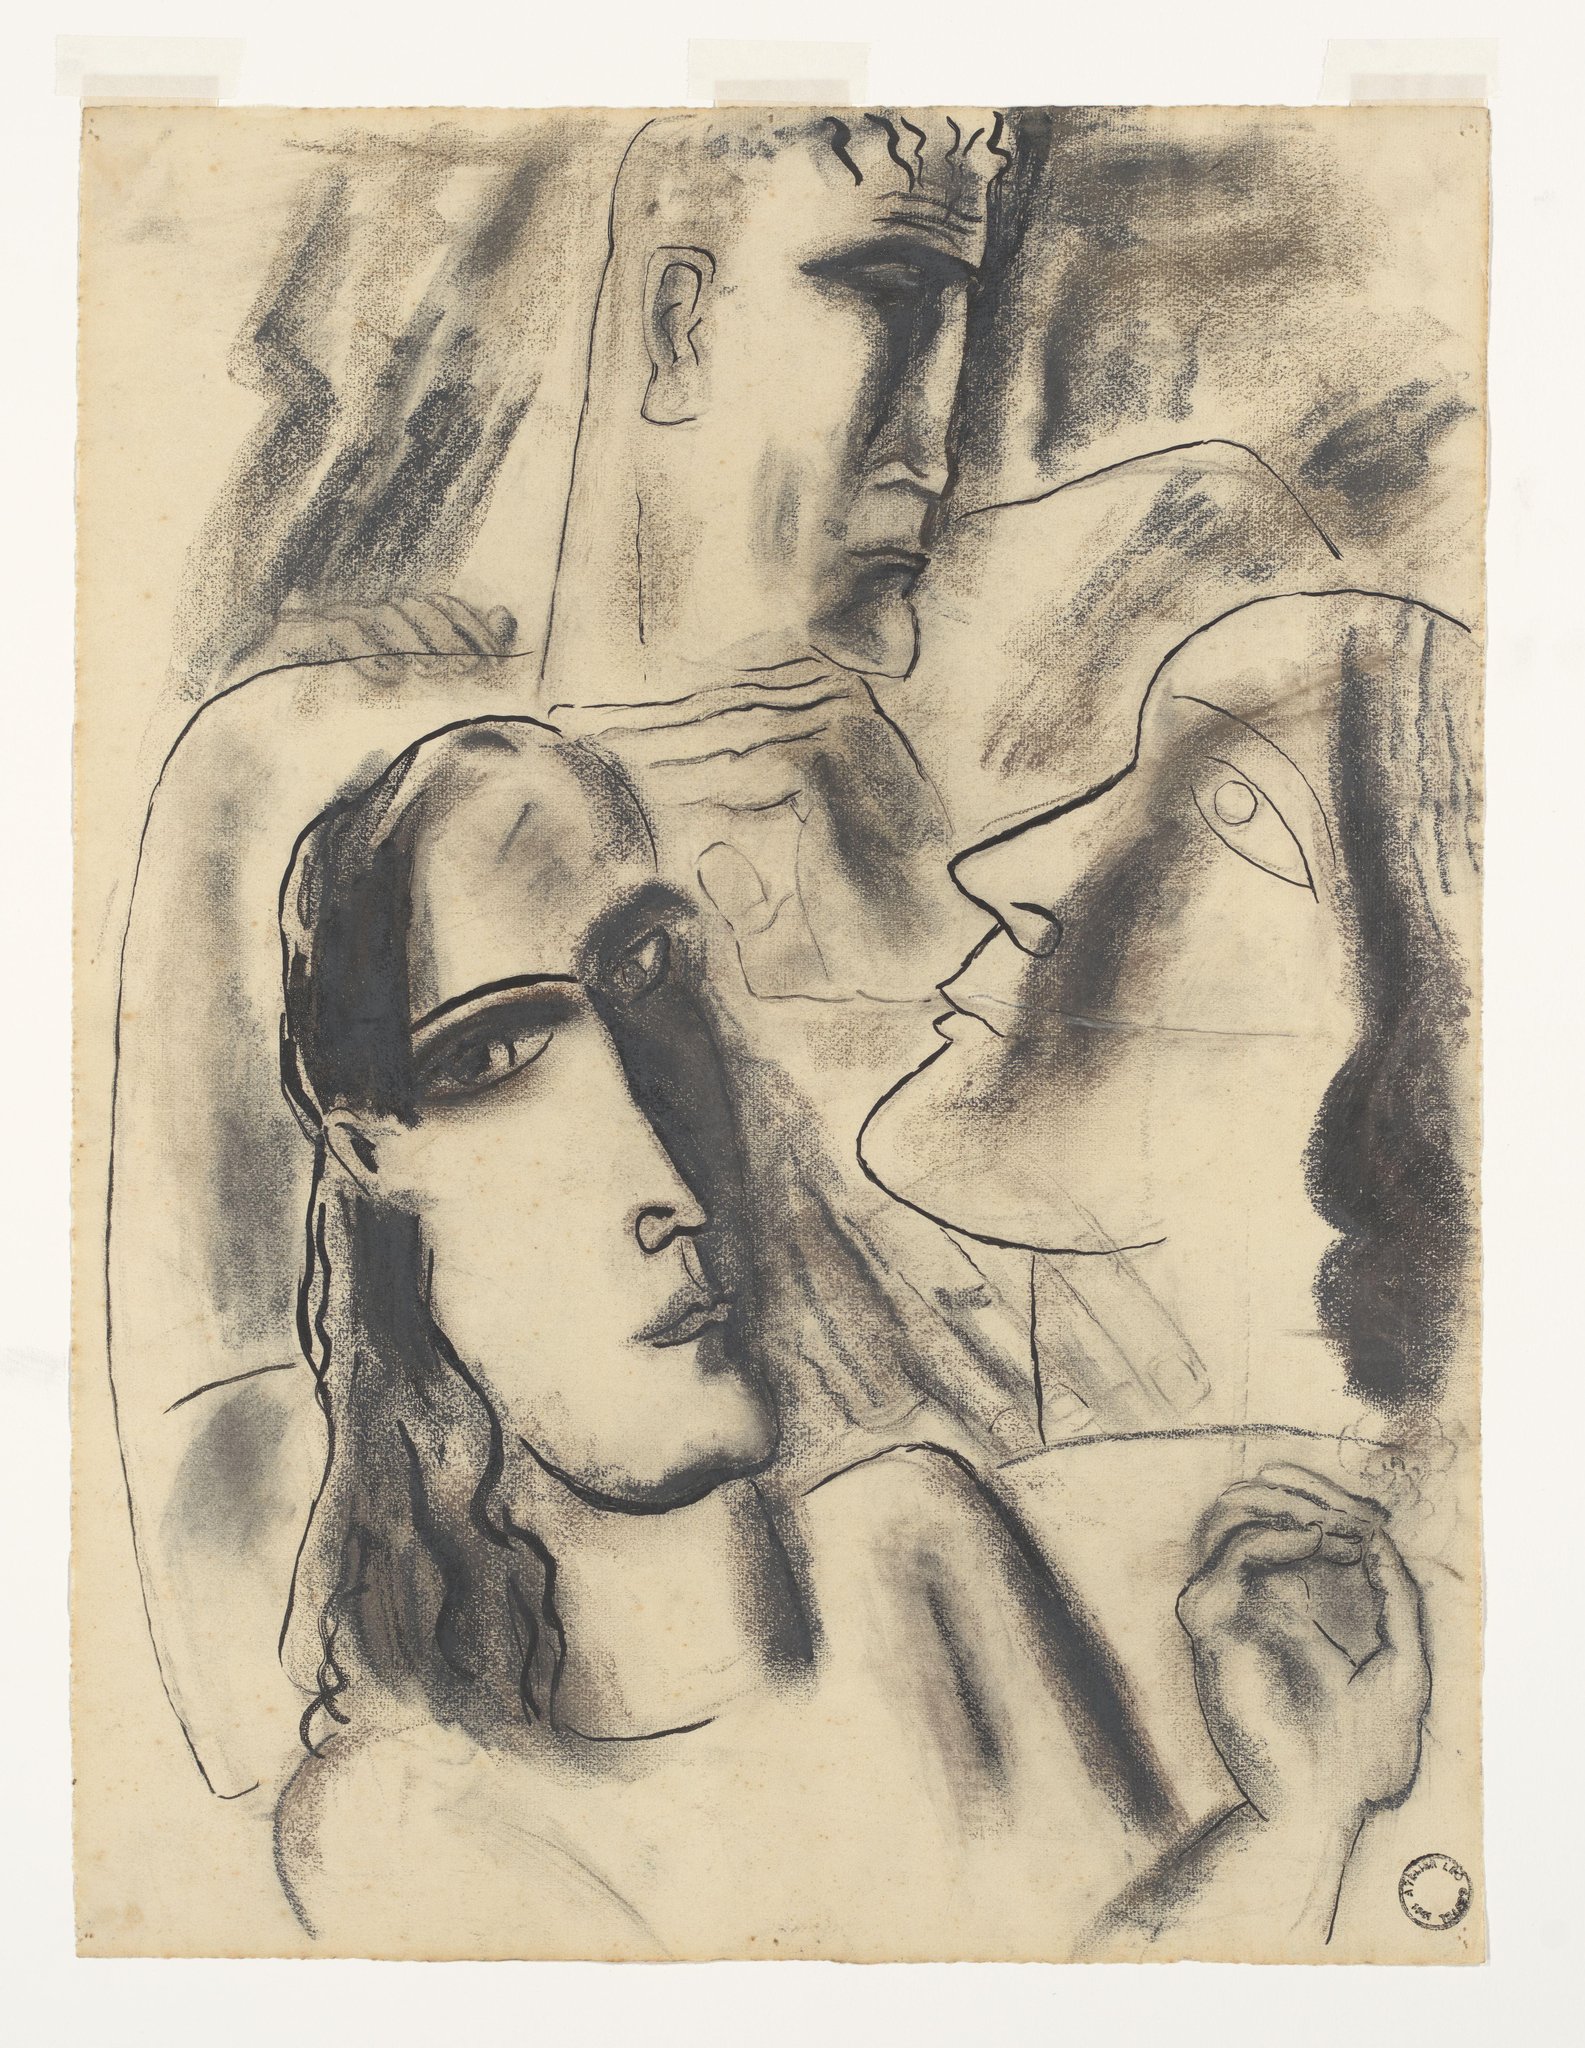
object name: drawing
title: Zonder titel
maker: leo gestel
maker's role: draughtsman, print maker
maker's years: 1881-1941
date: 1928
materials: chalk, ink, paper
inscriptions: workshop stamp: ‘ATELIER LEO GESTEL 1928’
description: Linksonder vrouwengezicht, midden rechts mannengezicht en profil, midden boven mannengezicht en profil.